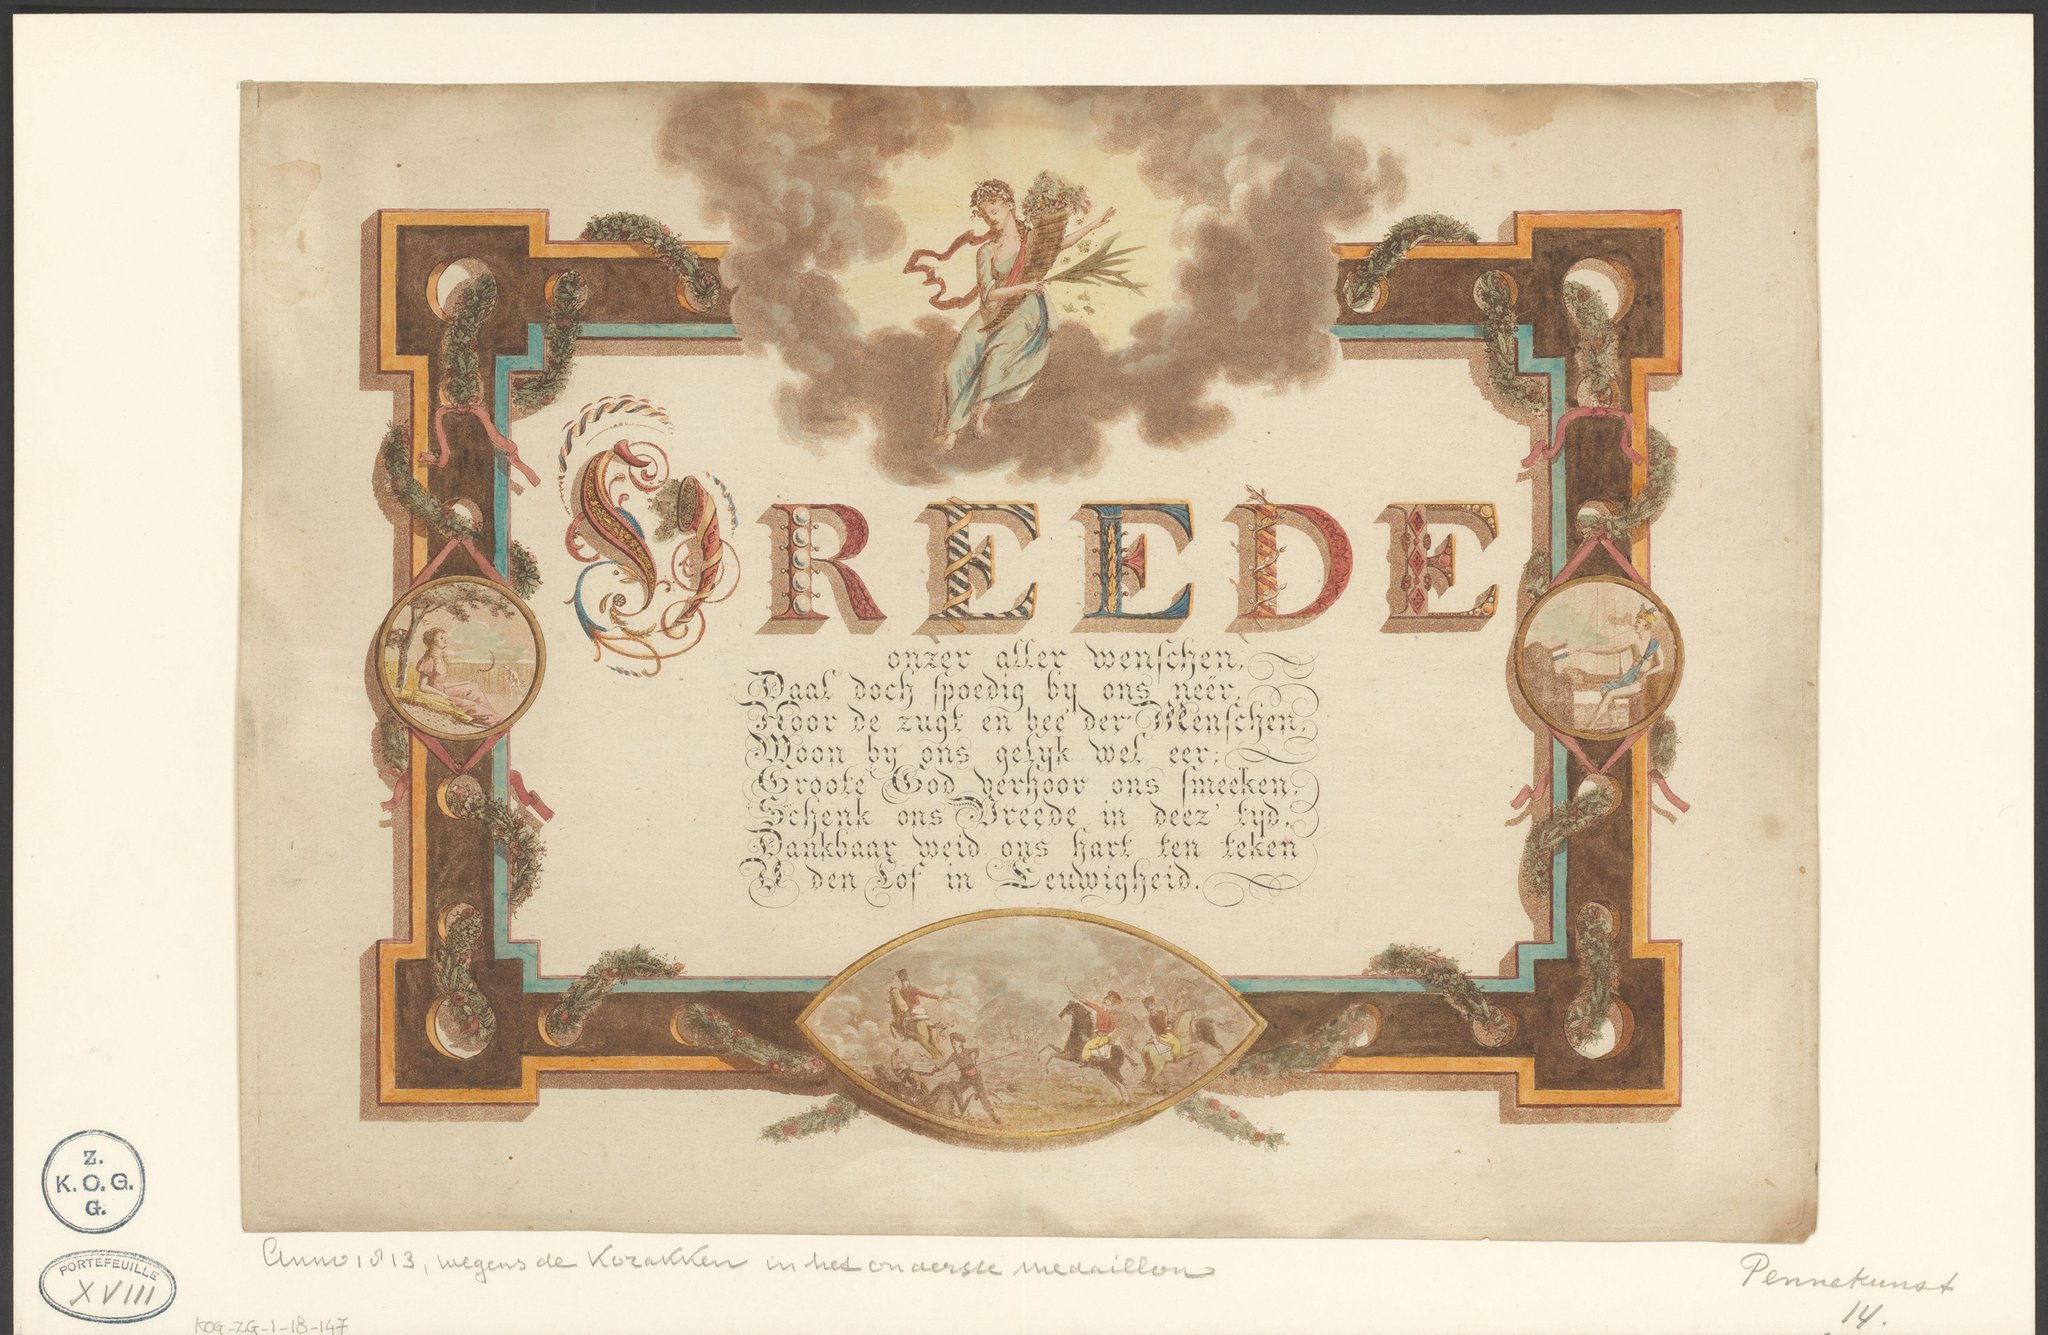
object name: drawing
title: Vreede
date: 1787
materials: paper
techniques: aquatint, etching, hand coloring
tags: battle, peace and prosperity, 'pax et abundantia', specific aspects, allegorical aspects of mercury; mercury as patron, ceres, patroness of agriculture, amsterdam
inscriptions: collector's mark: Lugt 1641, stamp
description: Pennekunst met de tekst: Vreede. Bovenaan de personificatie vrede met de hoorn des overvloeds. Links een medaillon met Ceres, de godin van de landbouw, met een korenschoof en sikkel. Rechts een medaillon met Hermes, de god van de handel, met een Zeilschip. Onderaan een medaillon met een veldslag met Kozakken. In 1813 bevrijden Russische Kozakkentroepen Amsterdam van de Fransen. Onderwerpsrubrieken binnen de Atlas Zeden en Gewoonten: Schoone kunsten, Pennekunst.